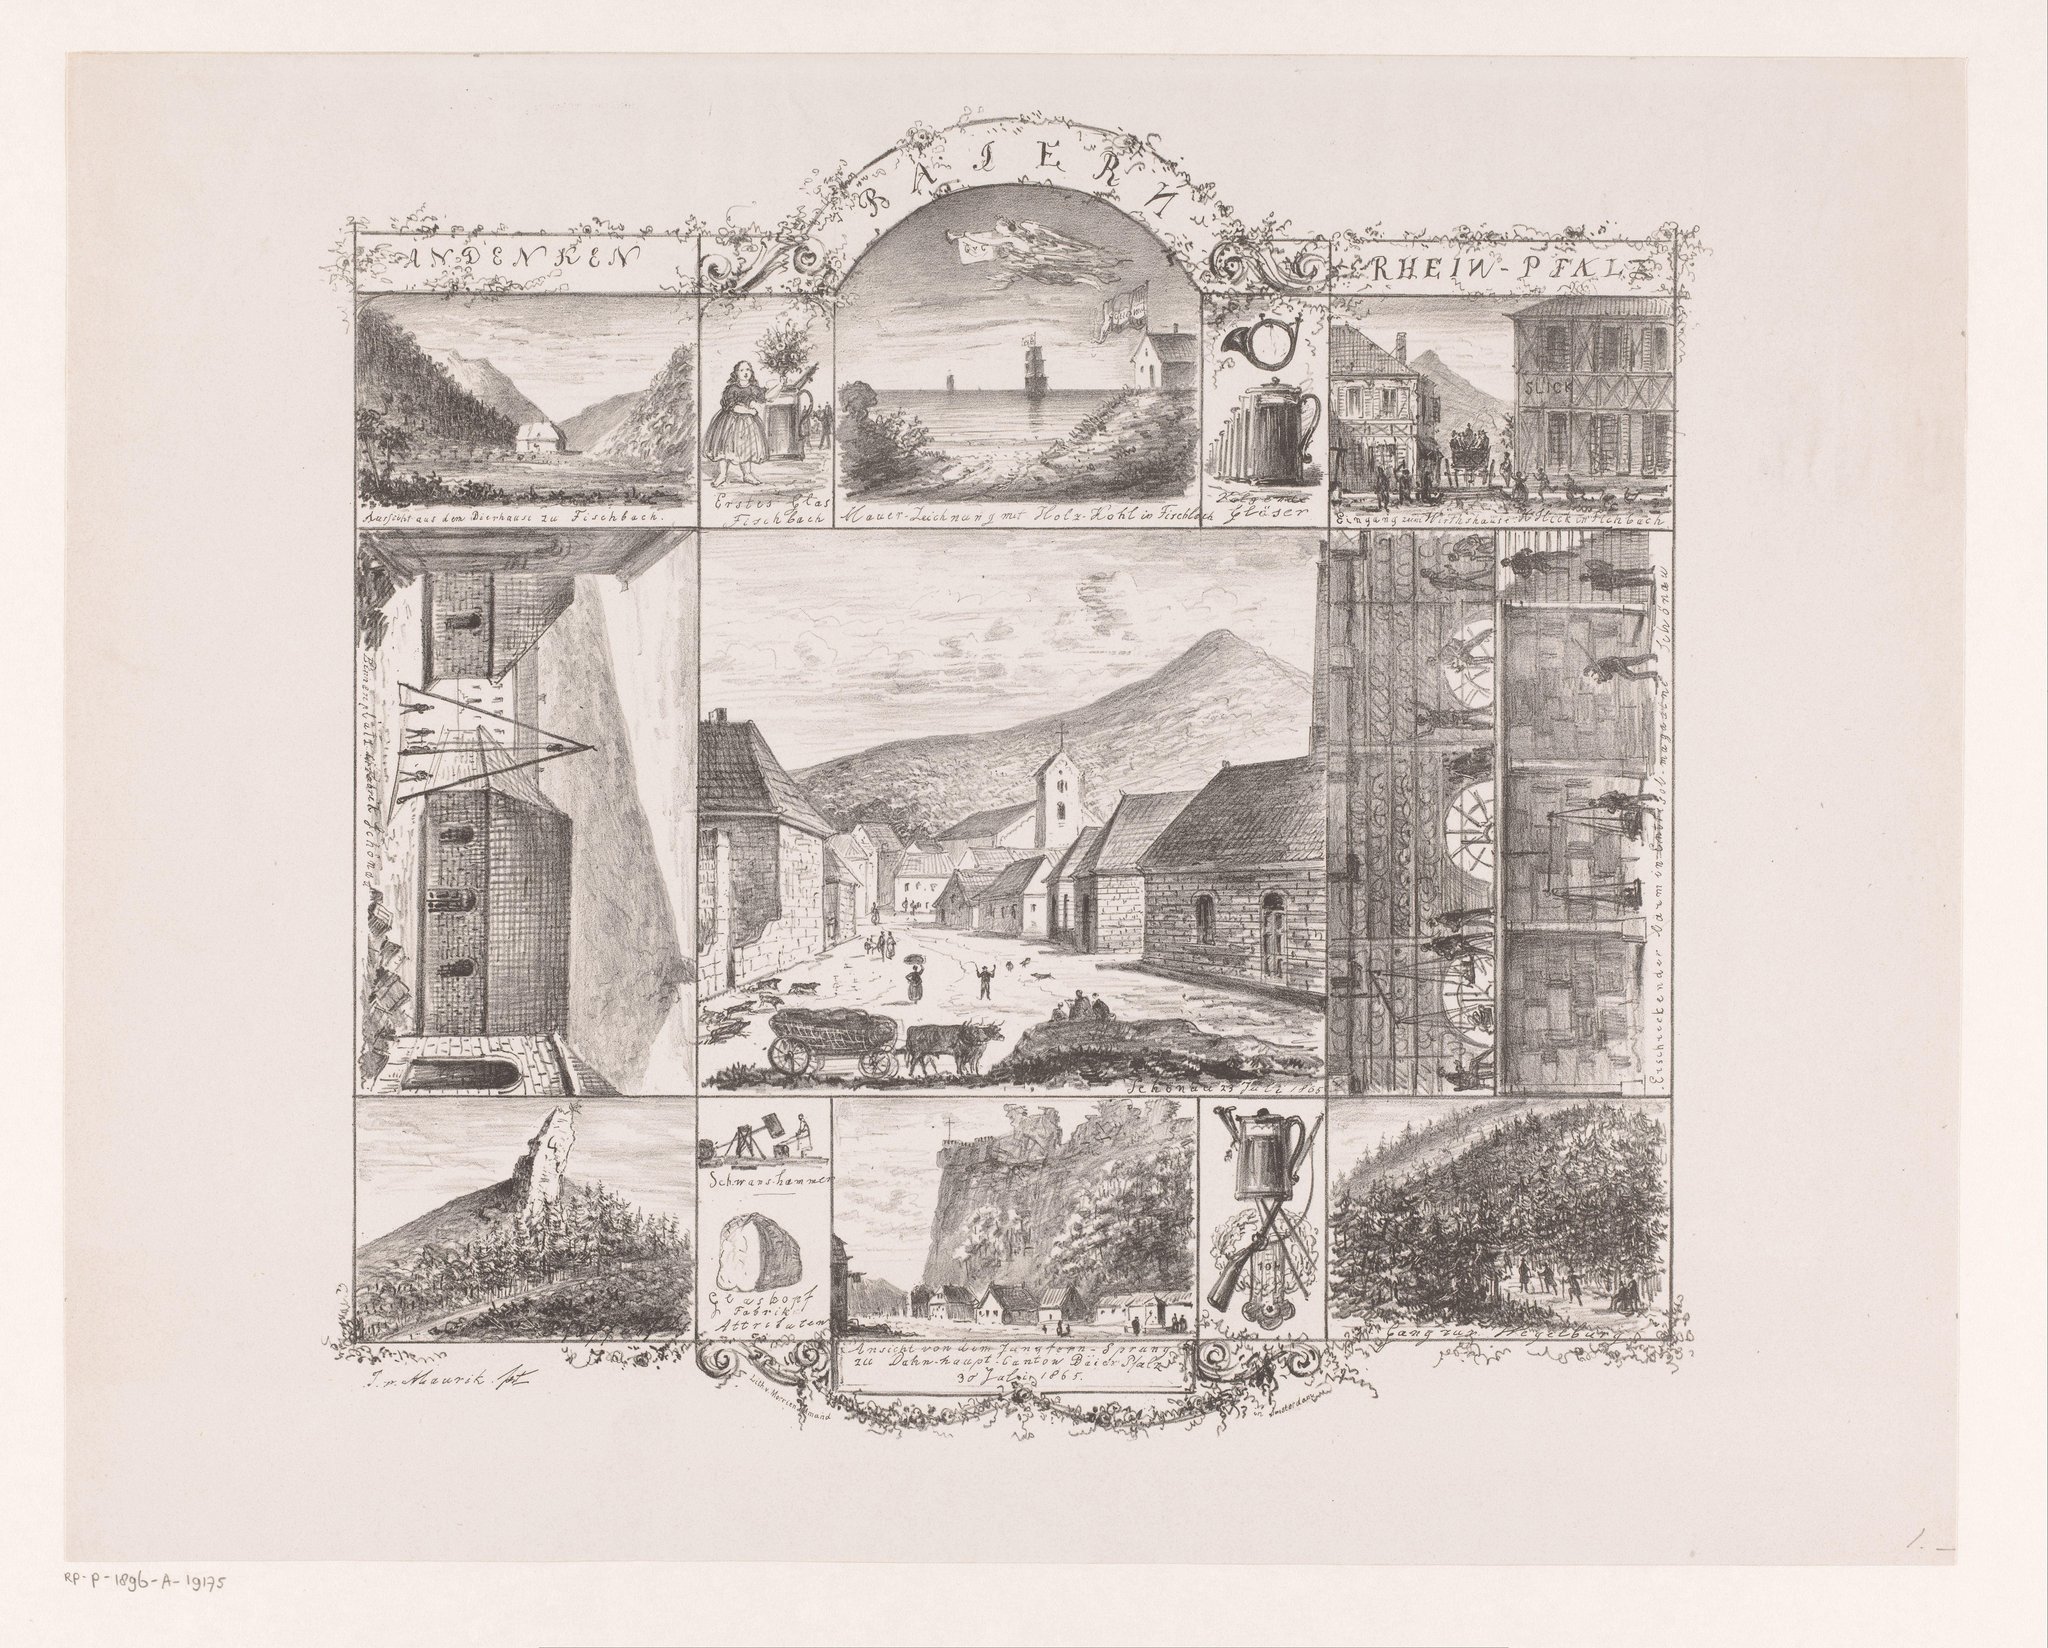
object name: print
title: Aandenken aan een bezoek aan de Beierse Palts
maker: justus van maurik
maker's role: print maker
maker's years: 1807-1890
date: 1865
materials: paper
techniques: lithograph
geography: amsterdam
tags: factory-building, souvenir (~ tourism), village street (+ city(-scape) with figures, staffage)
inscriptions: collector's mark: Lugt 2228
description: Dertien voorstellingen met onderschriften. Afgebeeld zijn onder andere een bierhuis in Fischbach en een gezicht op de binnenplaats van een fabriek in Schönau.